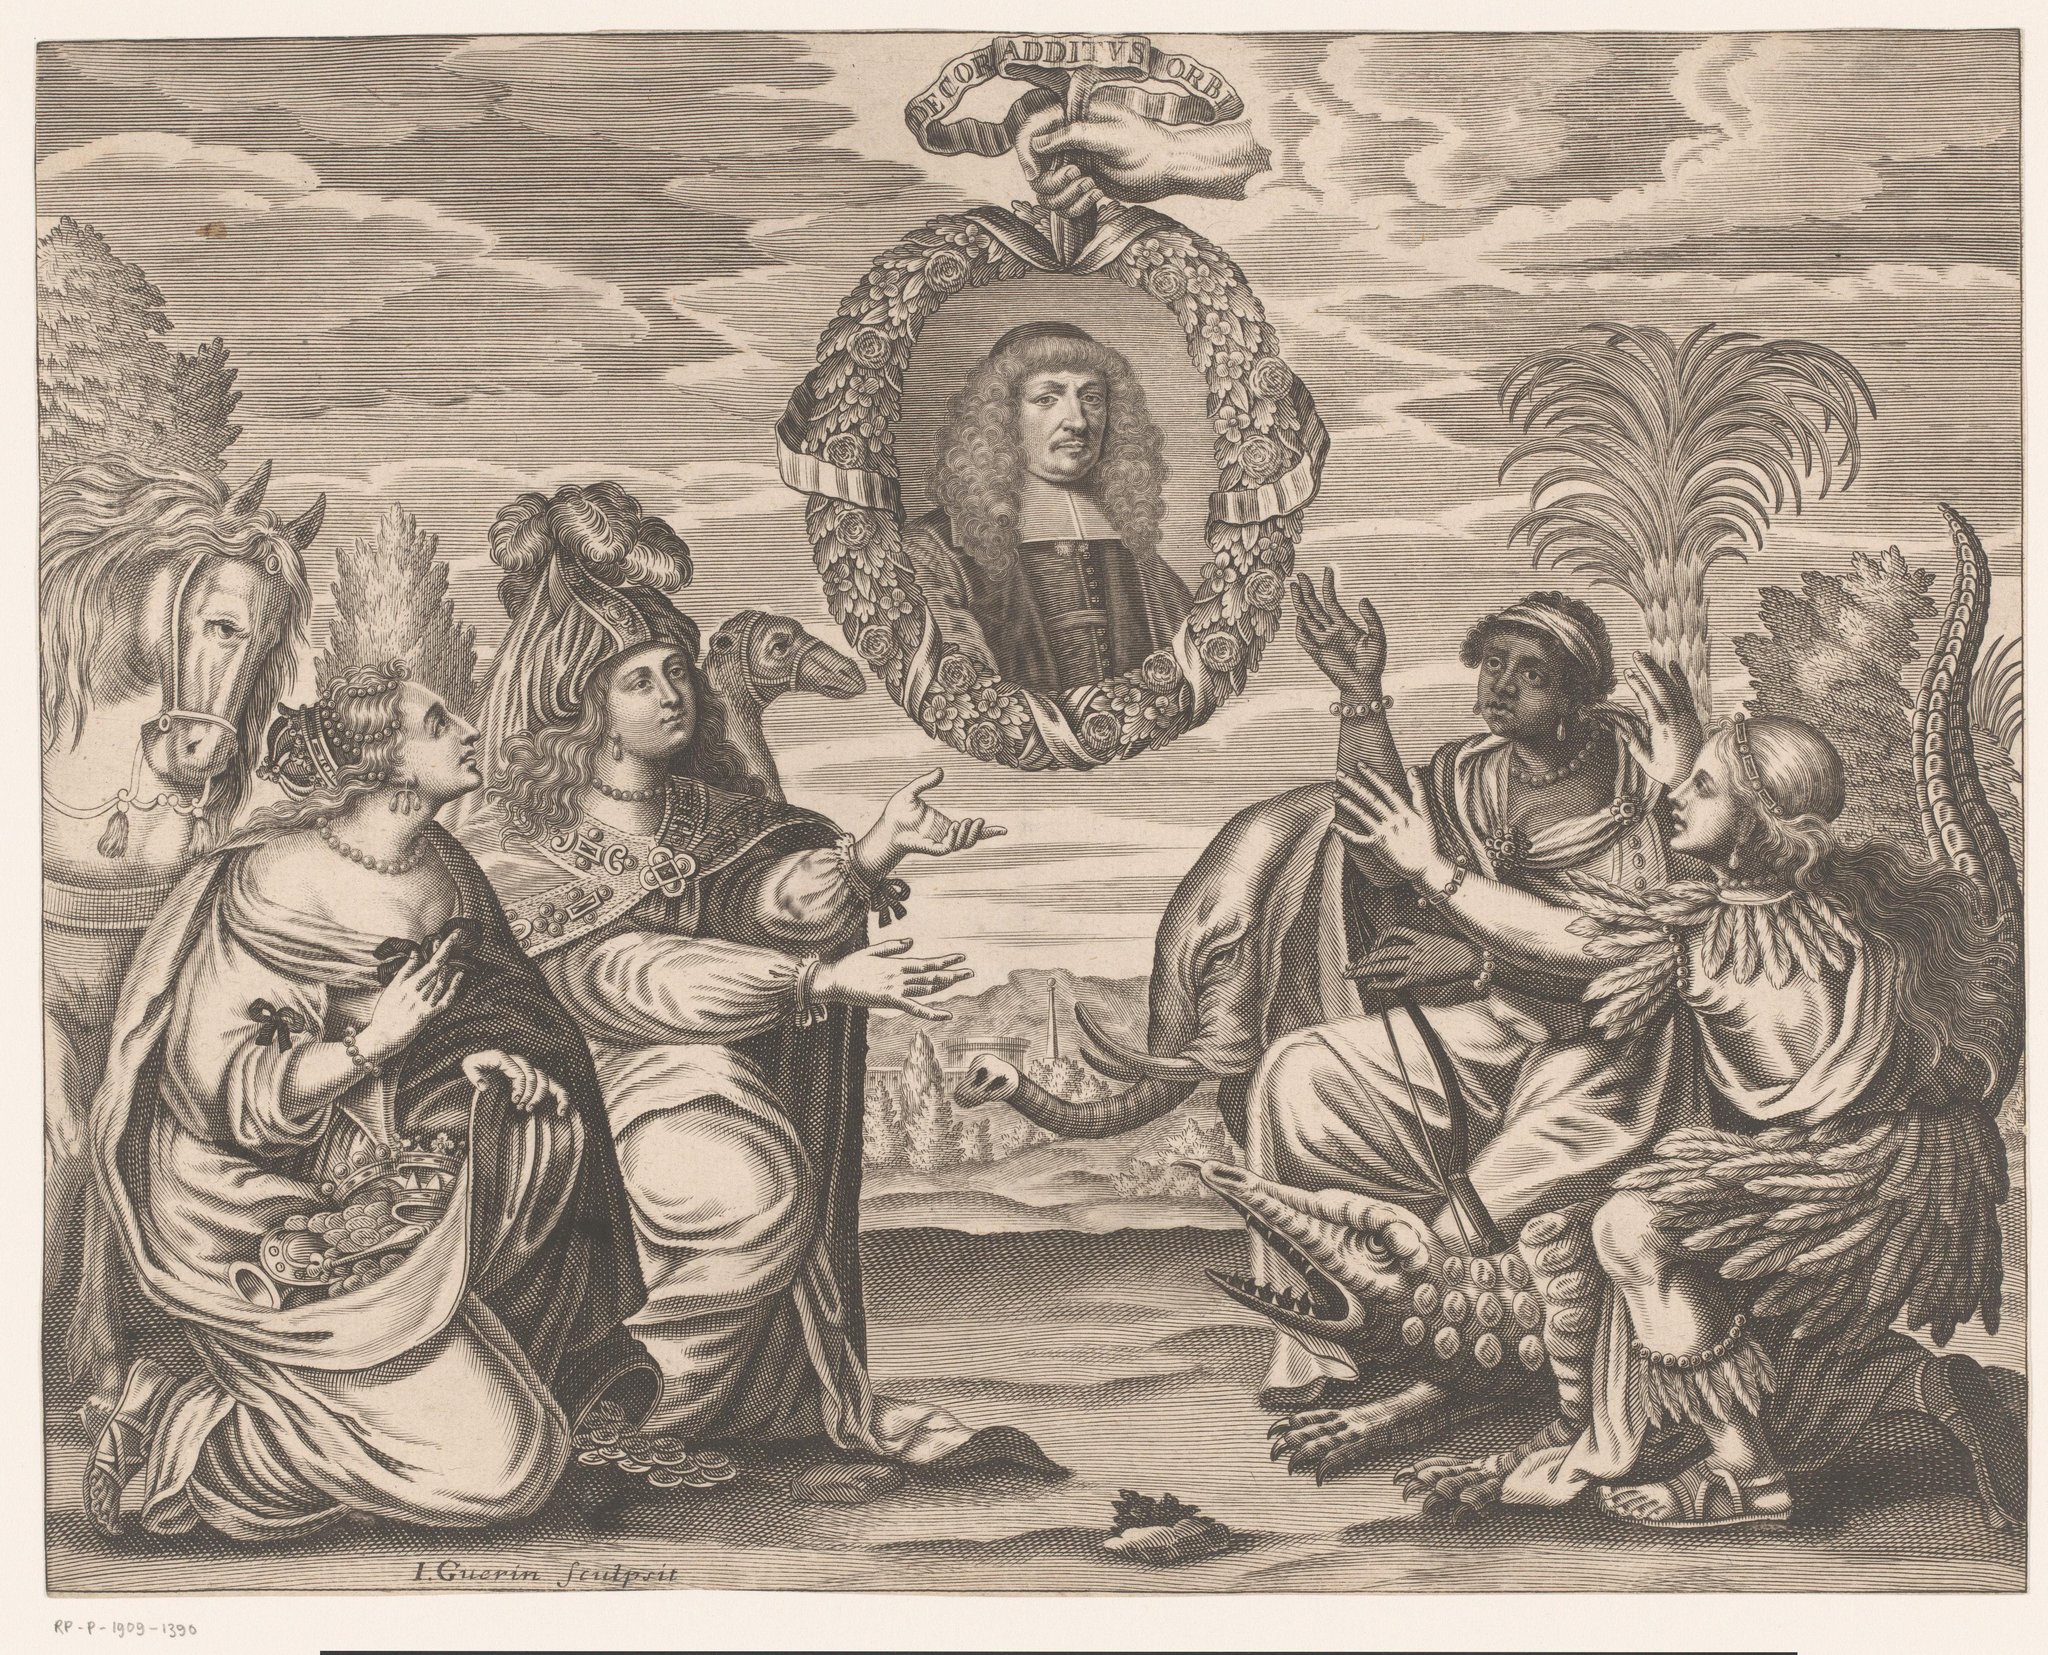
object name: print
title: Portret van Jacques Tuboeuf in een guirlande, omringd door de vier werelddelen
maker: jean guérin ( -1670)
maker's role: painter, print maker, publisher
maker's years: -1670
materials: paper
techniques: engraving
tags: politician, historical persons, continents represented allegorically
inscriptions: collector's mark: Lugt 2228, number: ‘CV, 17580’